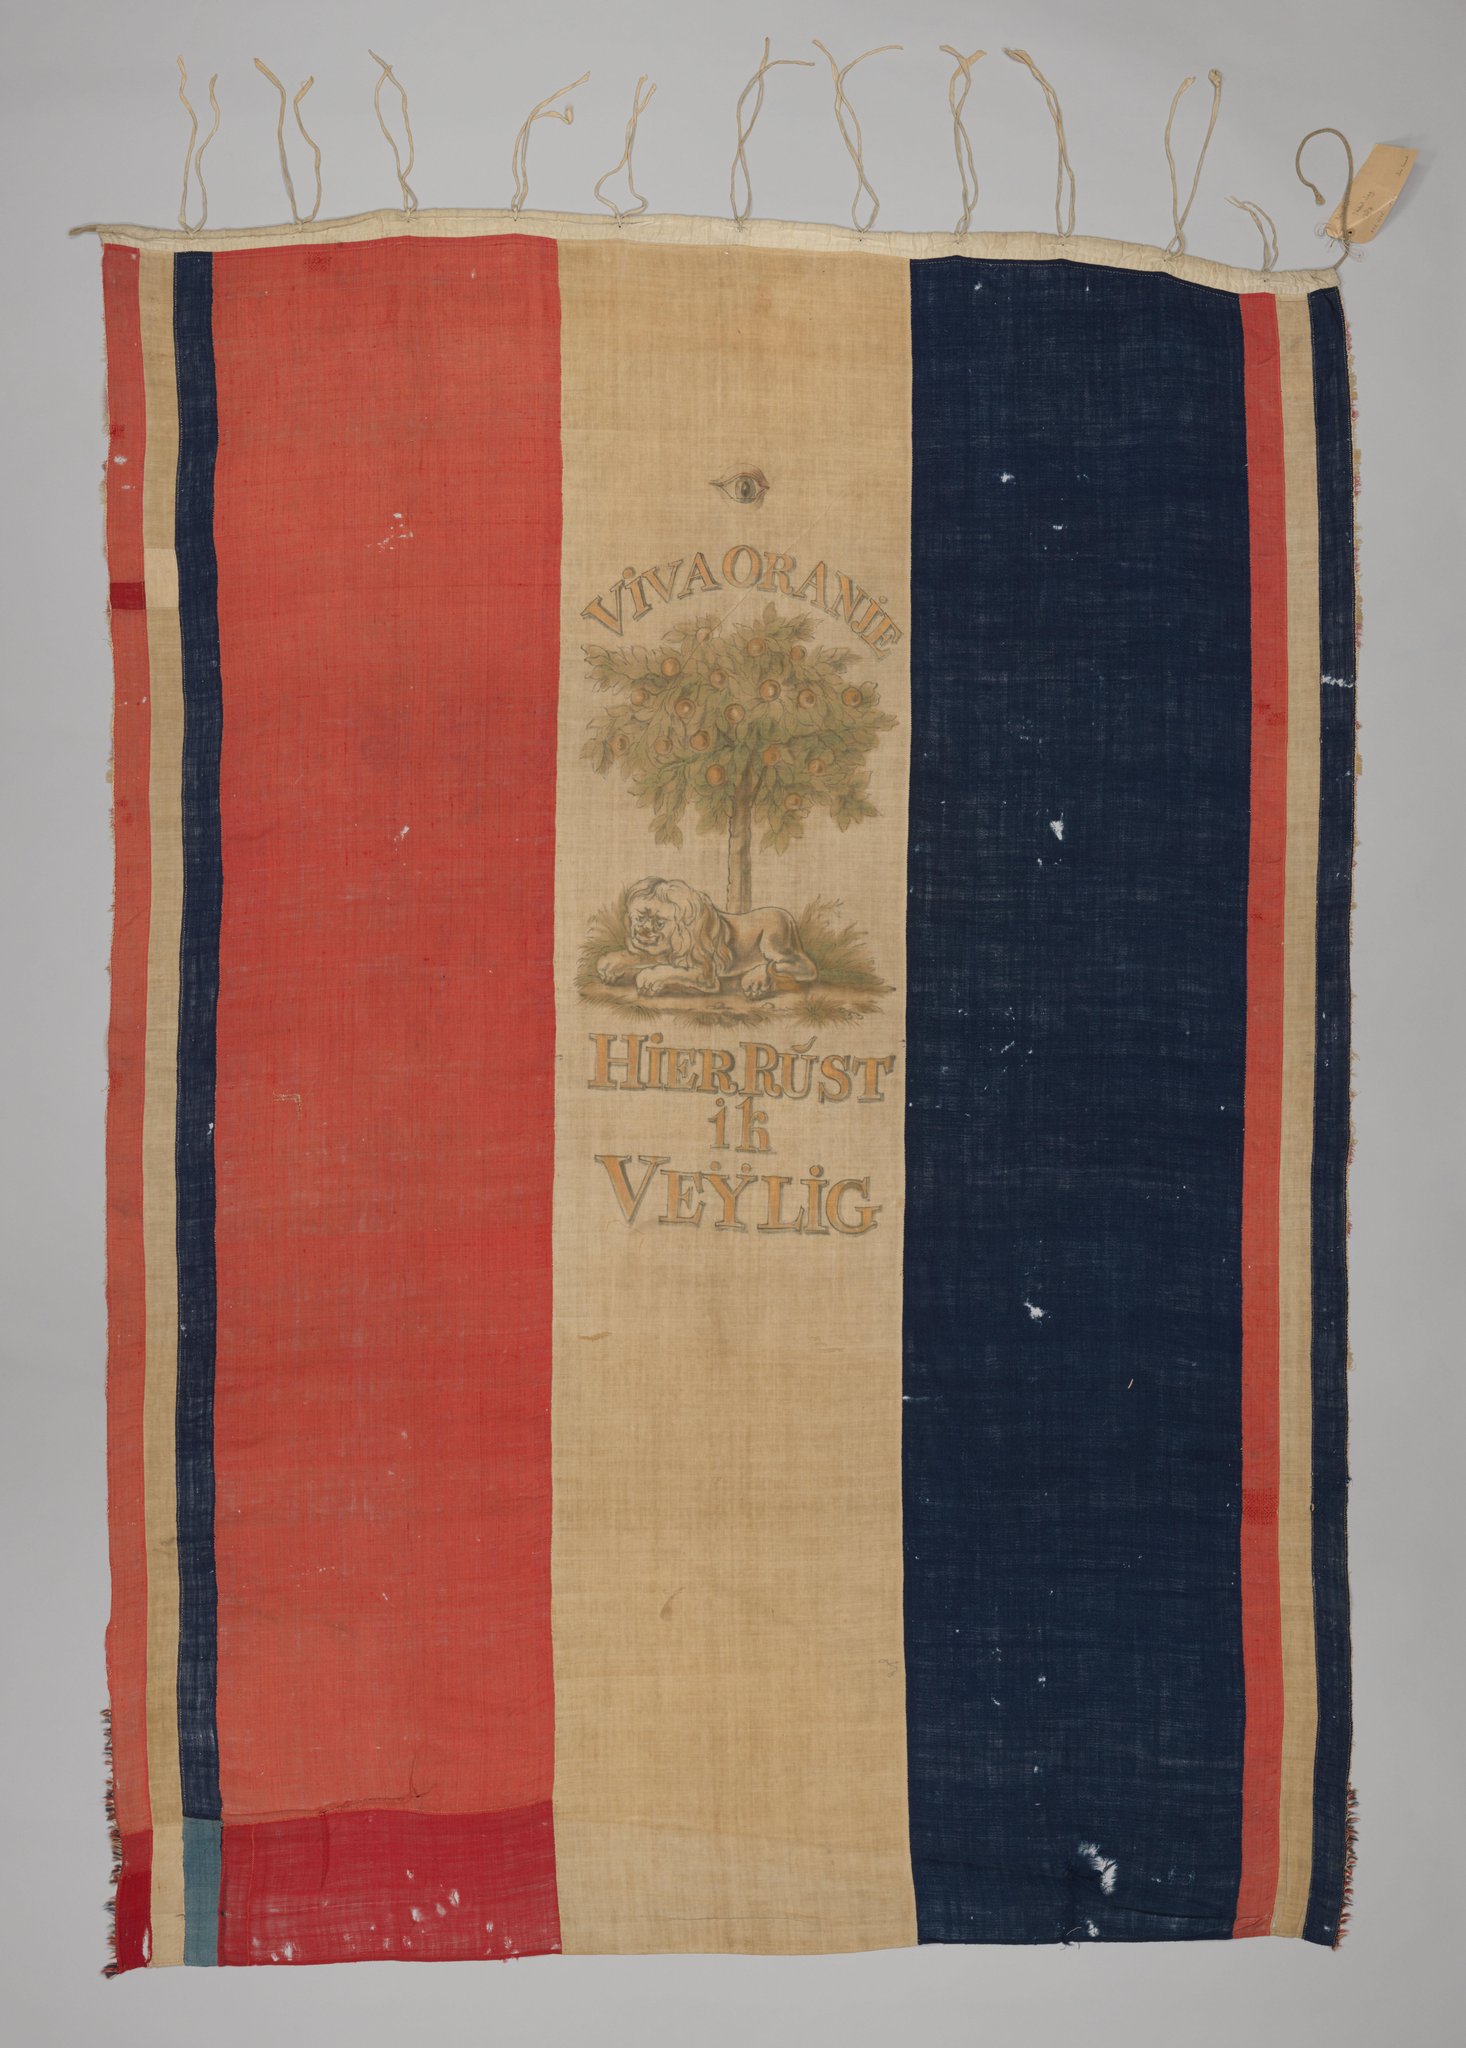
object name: flag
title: Nederlandse vlag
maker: Anonymous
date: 1787-1795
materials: linen, wool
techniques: painted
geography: netherlands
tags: netherlands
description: Vlag met banen rood-wit-blauw, langs boven- en onderzijden afgezet met smalle banen rood-wit-blauw, waarlangs franje rood-wit- geel; aan de vluchtzijde franje rood-wit-blauw. In de witte baan is met de vluchtzijde onderaan een groene boom vol oranjeappels geschilderd op een groen begroeid stukje grond. Onder de boom: een naar links gewende leeuw. In oranje kapita- len boven de boom: VIVA ORANJE en eronder: HIER RUST IK VEYLIG. Boven het opschrift een naar rechts ziend oog. Door de broek is een touw aangebracht waaraan elf paar lintjes zijn bevestigd.